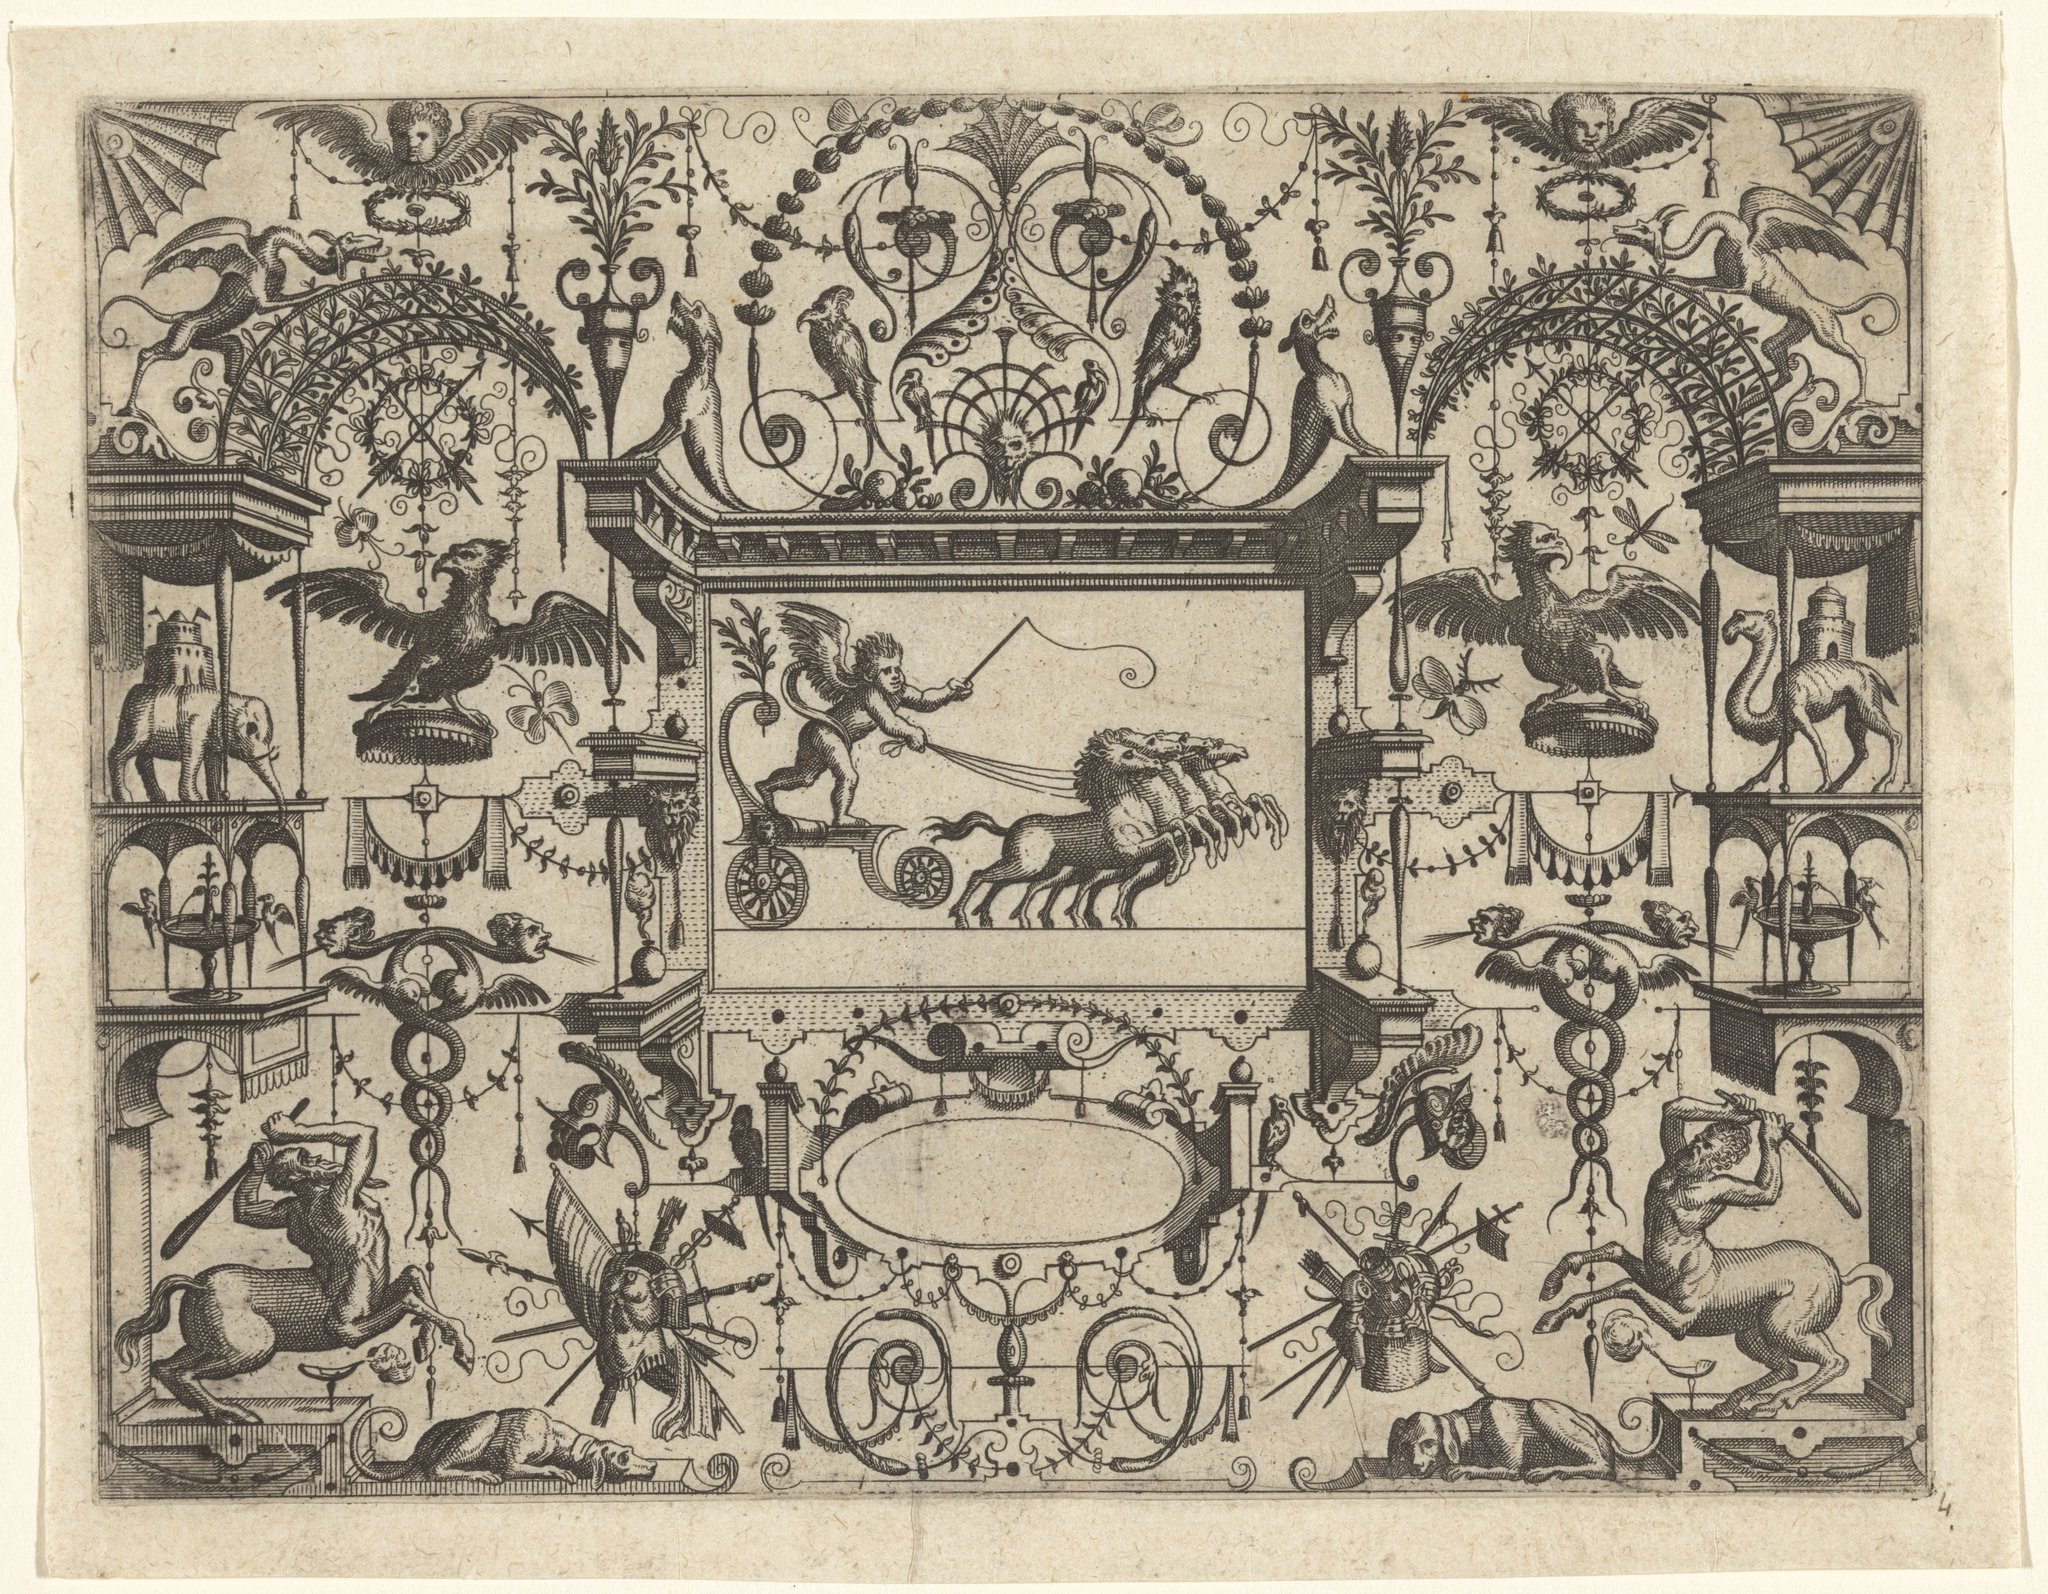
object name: ornament print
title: Grottesco: in diversche manieren…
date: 1565-1571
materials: paper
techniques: etching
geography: netherlands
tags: triumph of venus; 'carro di venere' (ripa), ornament ~ cartouche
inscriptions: inscription: ‘4’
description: Linksonder en rechtsonder staat een centaur met een knots. Uit serie van titelblad + 16 bladen met cartouches of architectuurfantasieën met een voorstelling in een omlijsting van grotesken met fabelwezens, dieren, guirlandes, trofeeën en mascarons.